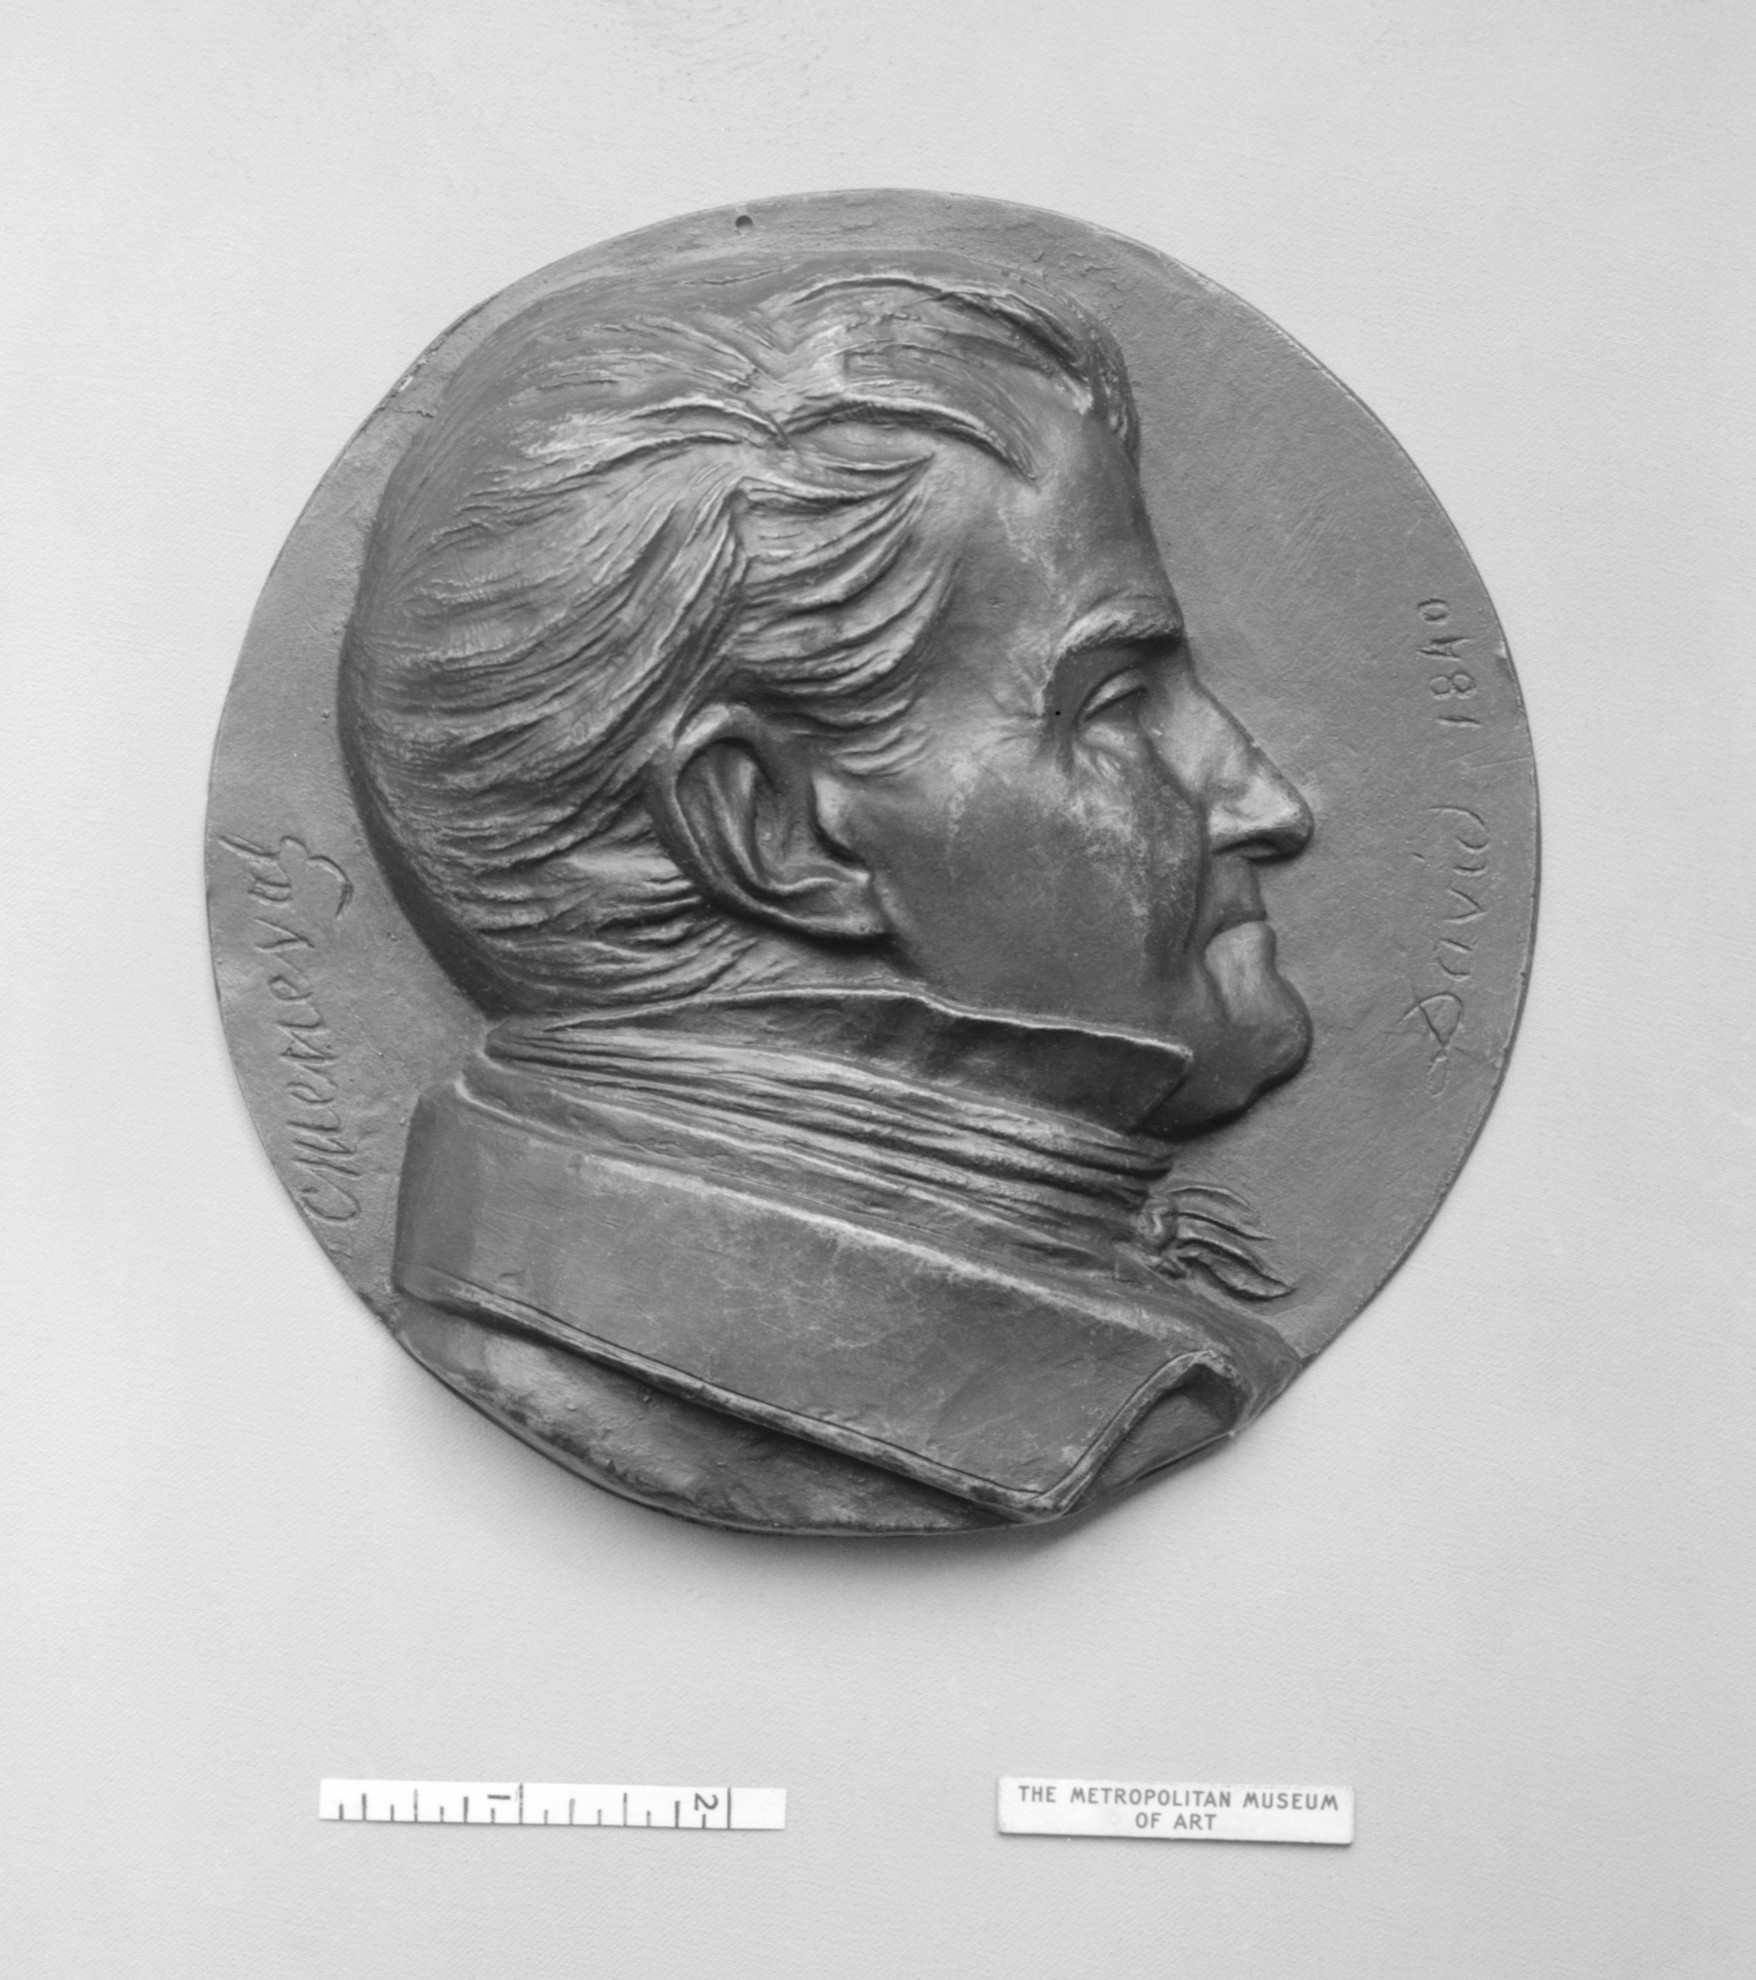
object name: medallion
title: Charles, Baron de Meneval (1778–1856), Secretary and librarian to Napoleon I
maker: pierre jean david d'angers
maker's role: artist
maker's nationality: french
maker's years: 1788-1856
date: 1840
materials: bronze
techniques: casting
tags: men,profiles